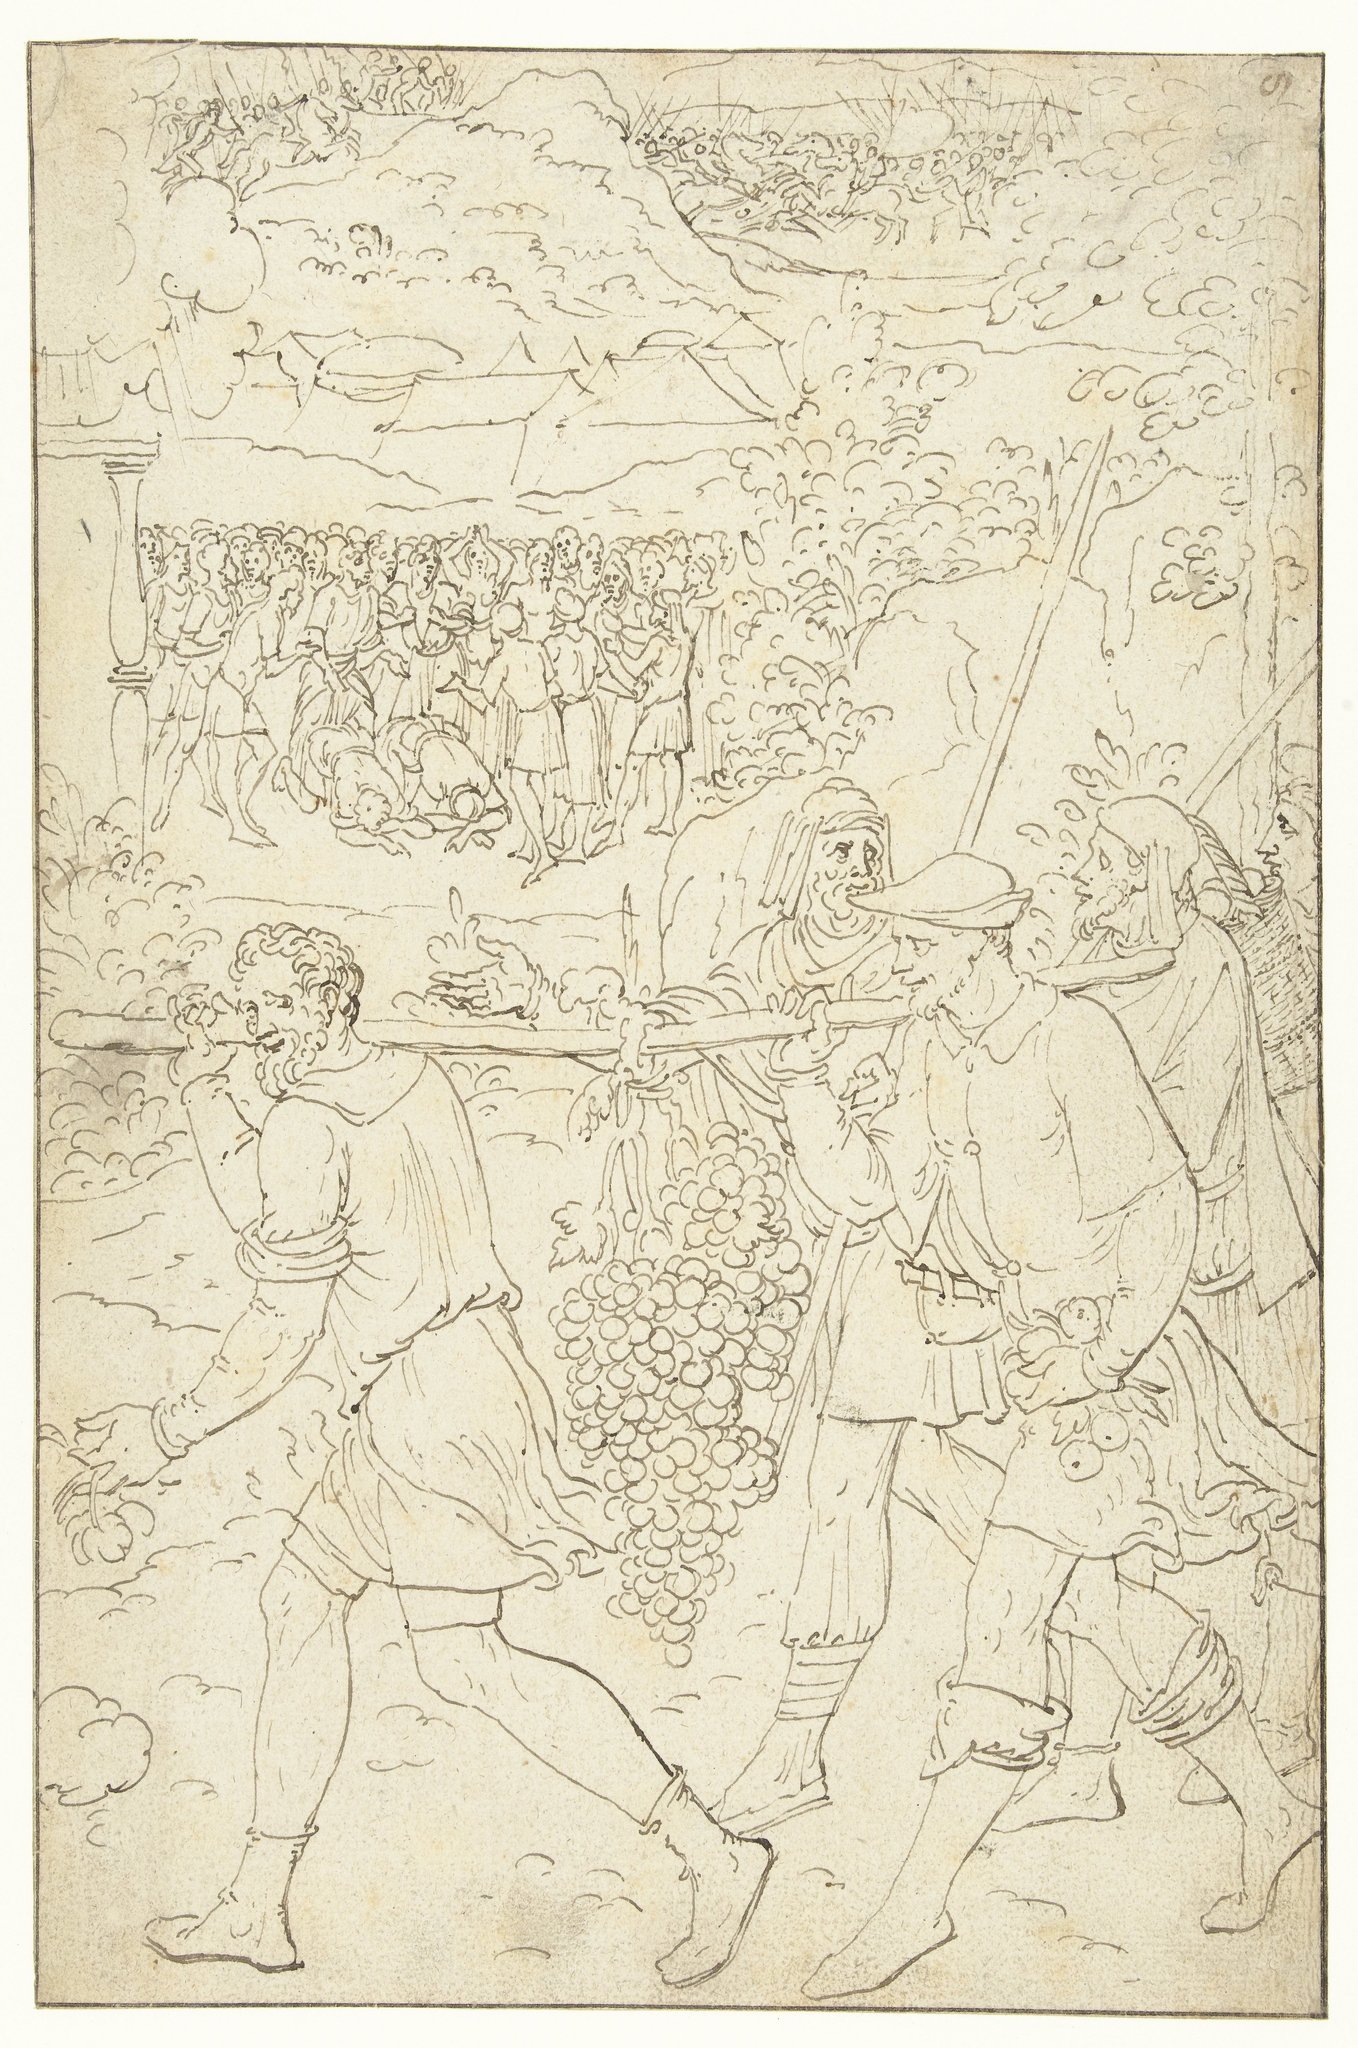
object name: drawing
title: Verspieders Jozua en Kaleb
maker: Anonymous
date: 1545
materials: ink, paper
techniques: pen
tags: the spies take away some of the fruits of canaan and return, usually carrying a large bunch of grapes on a pole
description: De verspieders Jozua en Kaleb keren terug uit Eskol met een wijnrank met druiven. Ontwerp voor een glasruit.